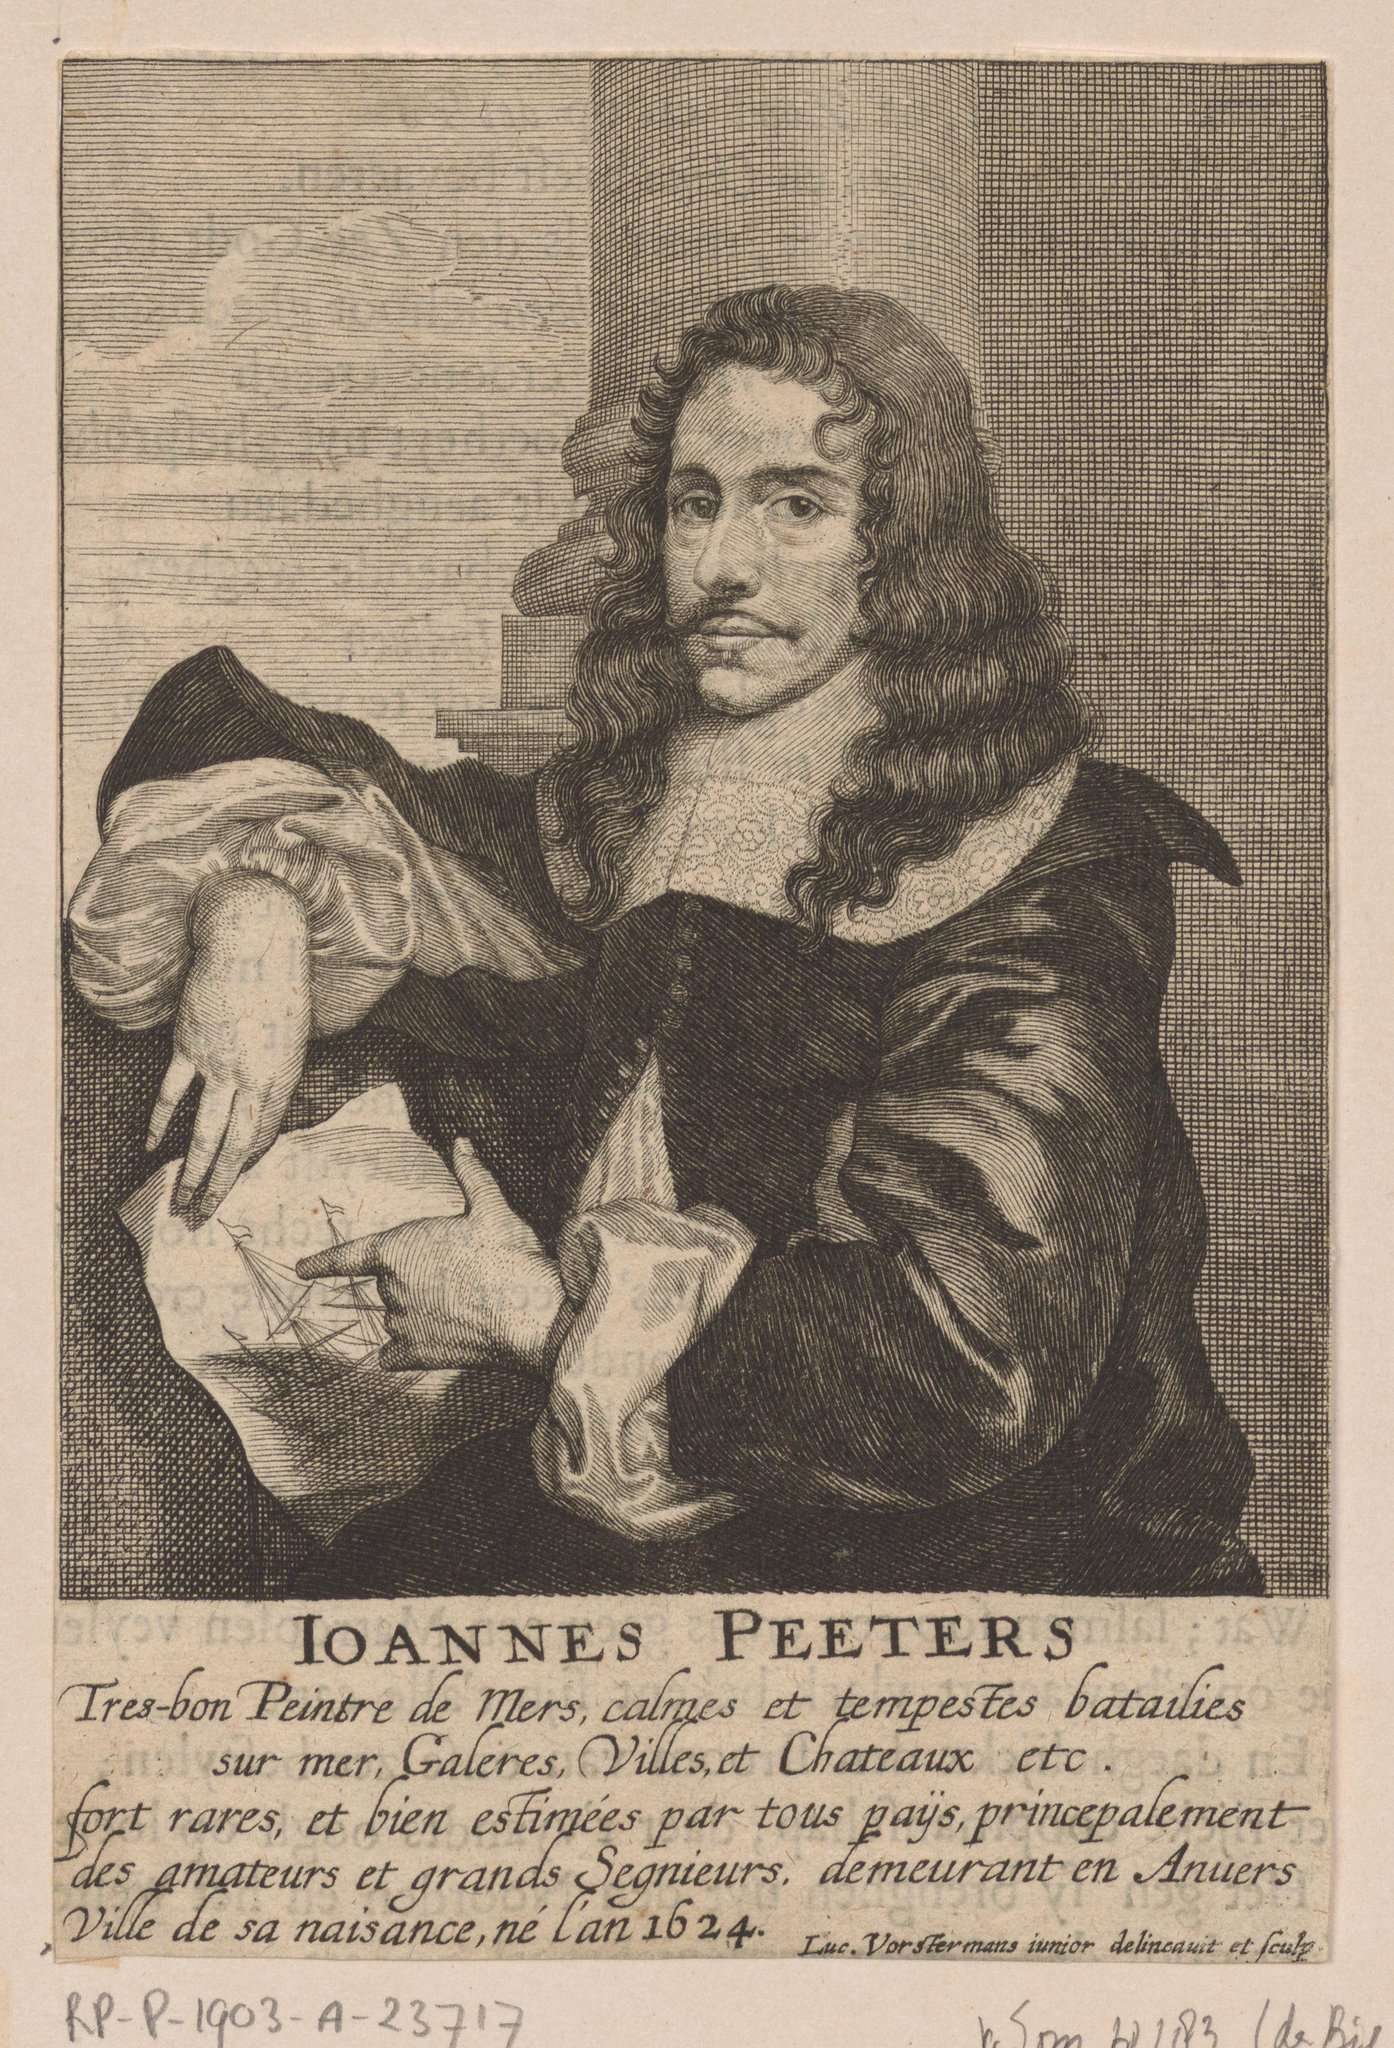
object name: book illustration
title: Portret van Jan Peeters I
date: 1662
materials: paper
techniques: engraving, letterpress printing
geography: antwerp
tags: antwerp, draughtsman, jan peeters (i), adult man, historical persons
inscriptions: collector's mark: Lugt 2228, collector's mark: Lugt 567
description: Prent uit: Bie, Cornelis de. Het Gulden Cabinet vande edel vry Schilder Const (...). 3 dln. Antwerpen: Joannes Meyssens, 1662 [1661 foutief op titelpagina].